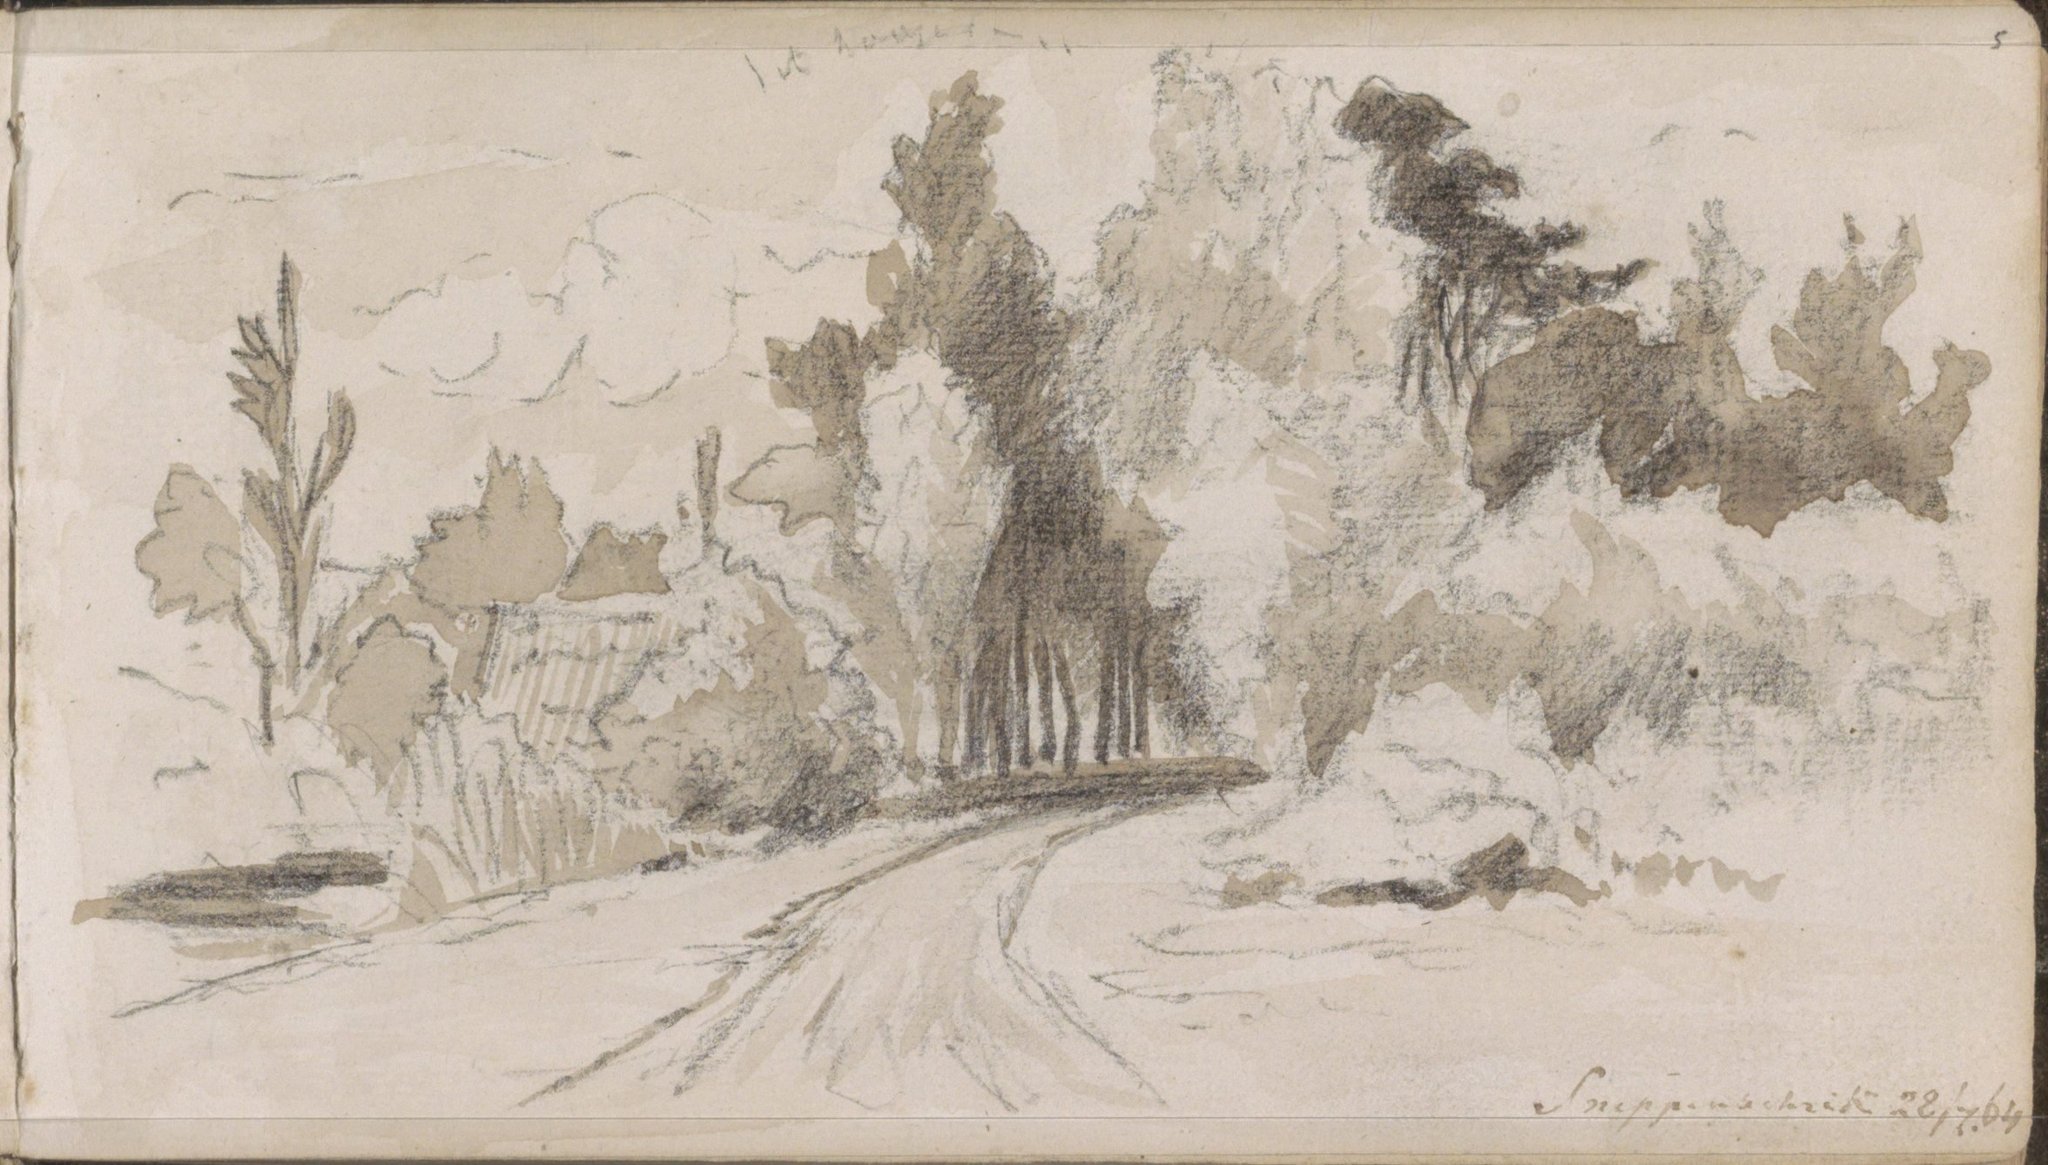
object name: sketchbook leaf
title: Landweg bij Sneppenschrik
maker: johannes tavenraat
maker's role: draughtsman, painter, print maker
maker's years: 1809-1881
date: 1807-1864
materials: ink, paper, pencil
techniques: brush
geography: capelle aan den ijssel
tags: trees, road, path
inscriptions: date and inscription: ‘Sneppenschrik 28/7 64’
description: Blad 5 recto uit een schetsboek met 98 bladen.